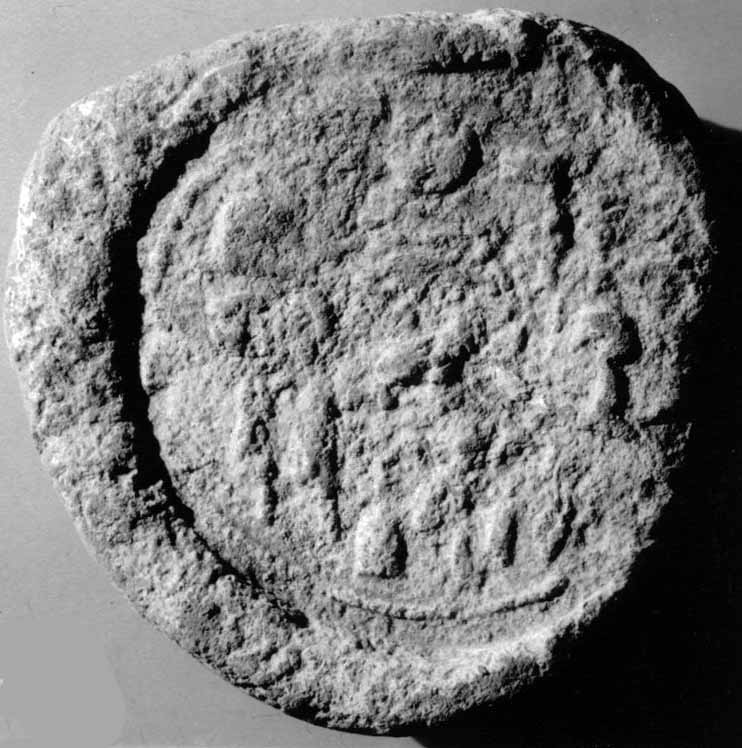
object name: cone, circular stamp, sennetjer, scribe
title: Funerary Cone of the Scribe Sennetjer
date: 1550-1295 BCE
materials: pottery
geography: egypt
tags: hieroglyphs